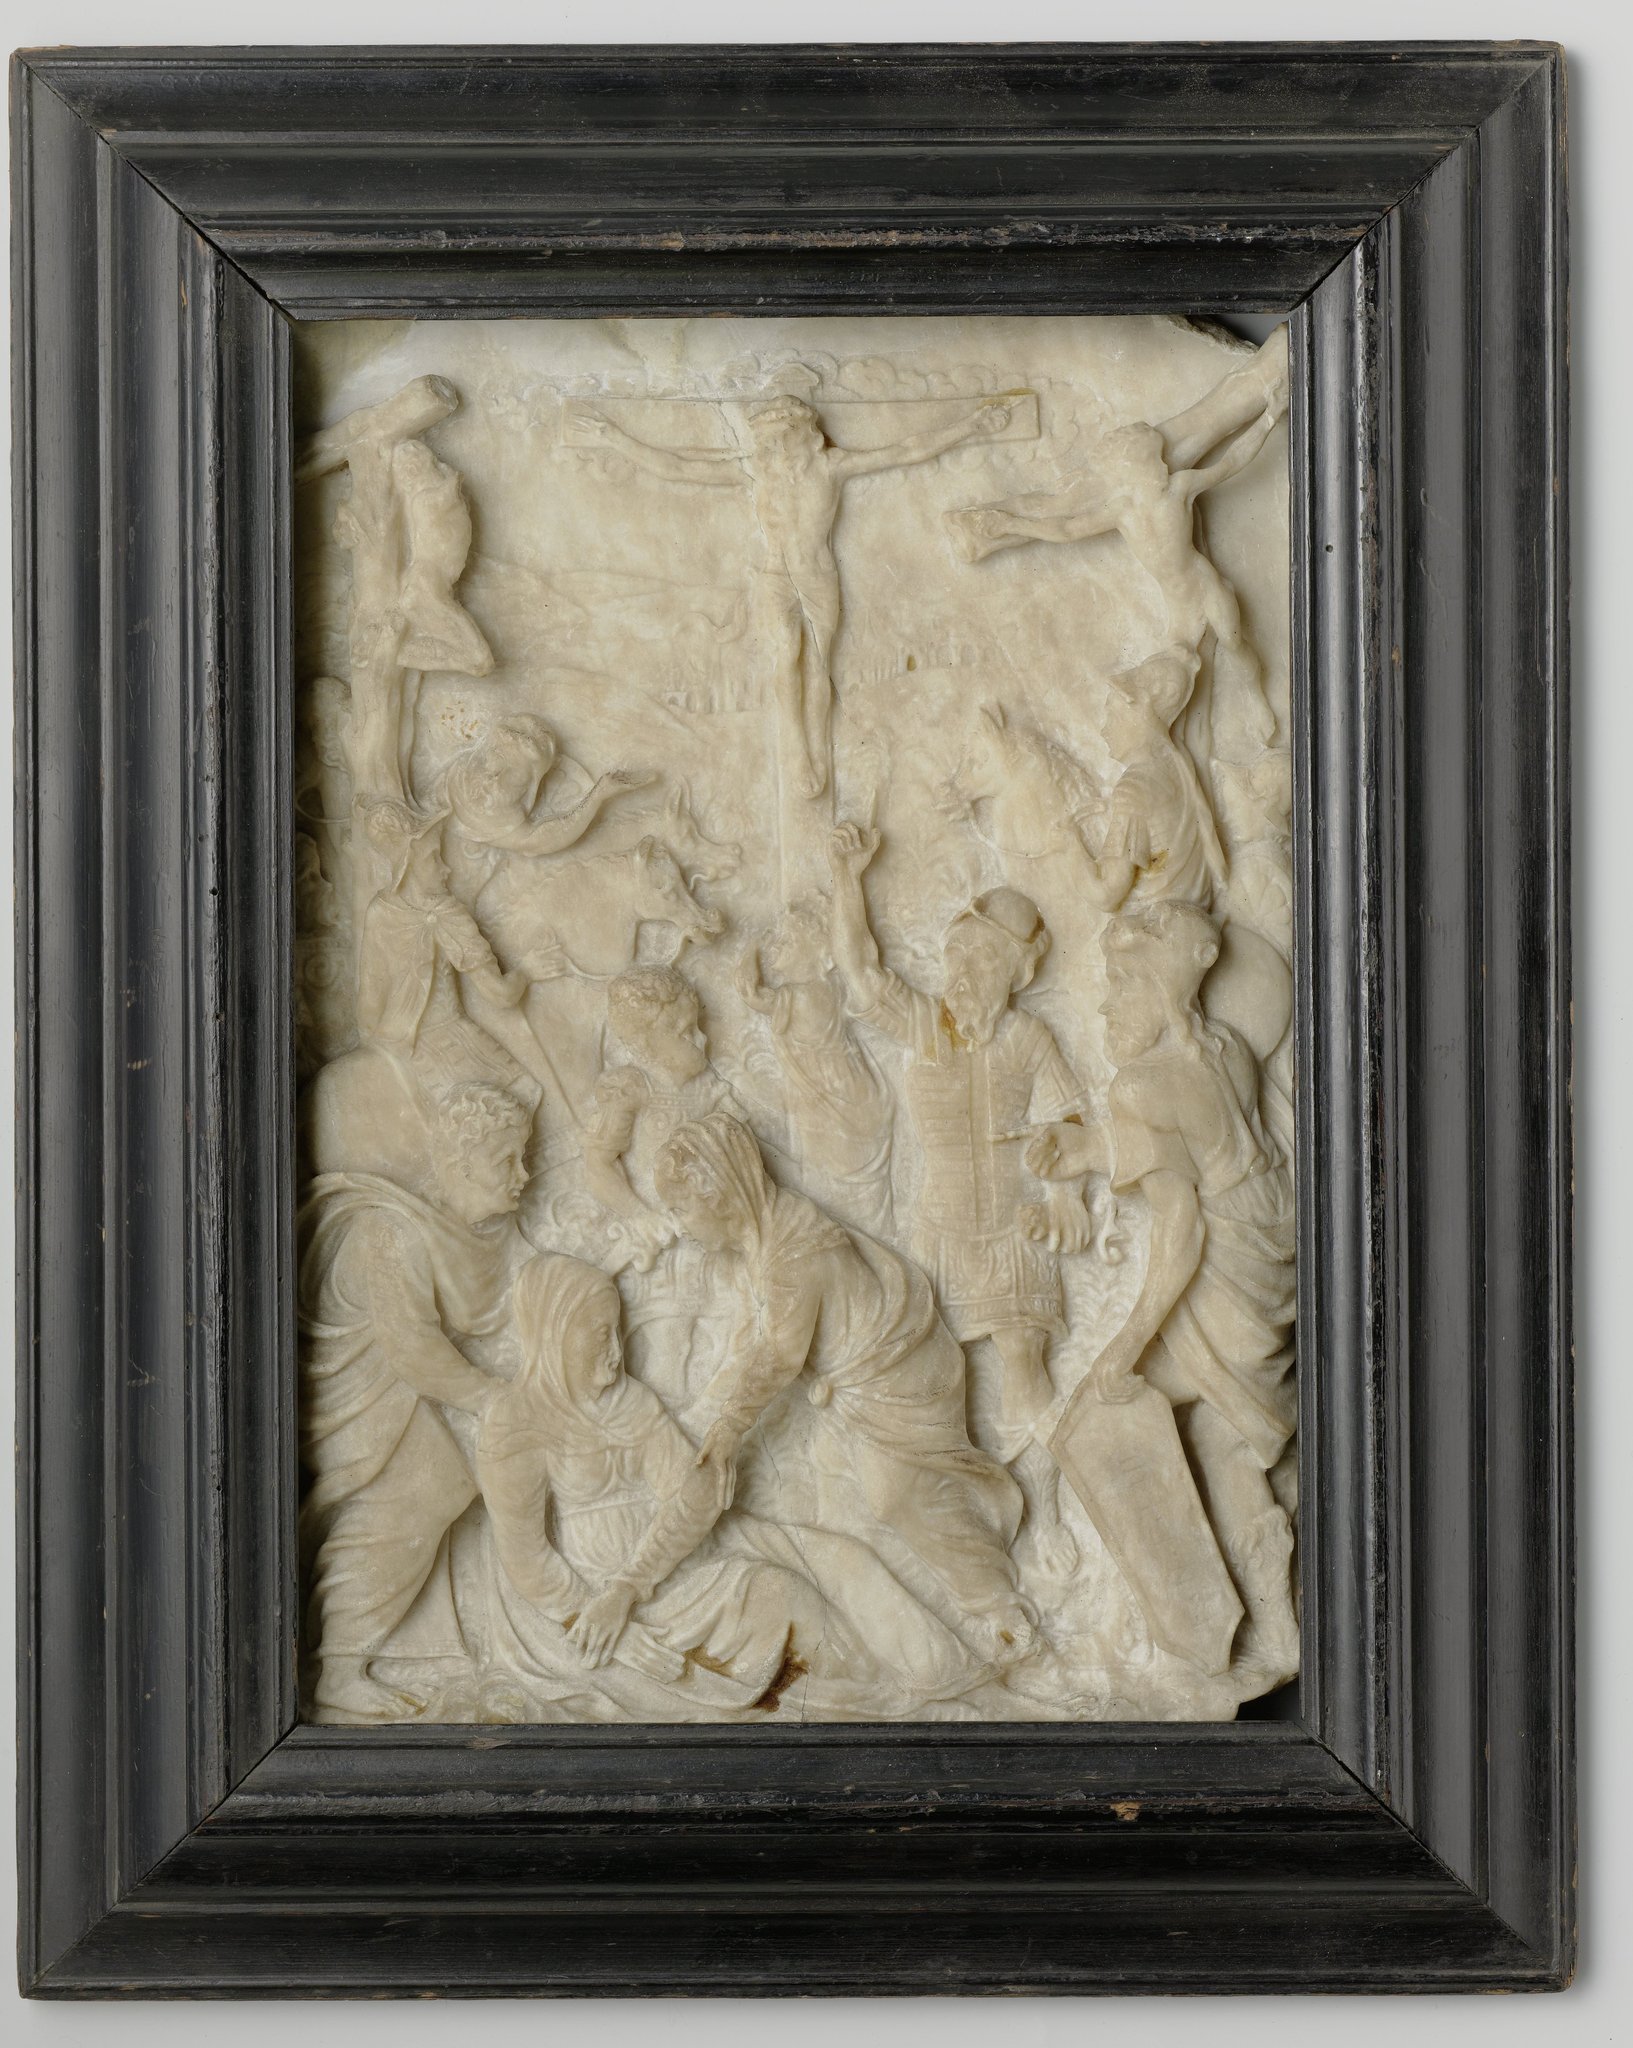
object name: sculpture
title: Calvary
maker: Anonymous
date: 1575-1600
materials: alabaster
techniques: gilding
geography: mechelen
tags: comprehensive representations of the events on golgotha during christ's hanging on the cross, no particular event emphasized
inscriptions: inscription, on the escutcheon, in recessed relief: ‘F.N.F. I 4 II’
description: In het midden hangt Christus aan een frontaal geplaatste kruis tussen de schuingeplaatste kruisen met beide naakte moordenaars. Links vooraan valt Maria in zwijm, bijgestaan door St. Jan en een heiloge vrouw. Achter hen een jongen met een dolk, twee ruiters naar rechts en een naar links en een voetknecht. Rechts vooraan staan twee soldaten van wie de ene een schild houdt en de andere met de rechter hand omhoog wijst en met de linker zijn dolk omvat. Achter hen een ruiter naar links, gevolgd door een voetknecht met schild. In het midden omarmt Maria-Magdalenen het kruishout. De achtergrond geeft een heuvelig landschap met bouwwerken en vegetatie. Ruiters en voetknechten zijn in pseudo-Romeins kostuum ; twee dragen een leeuwekop als hoofddeksel. Op het schild de initialen F.N.F.14 II.